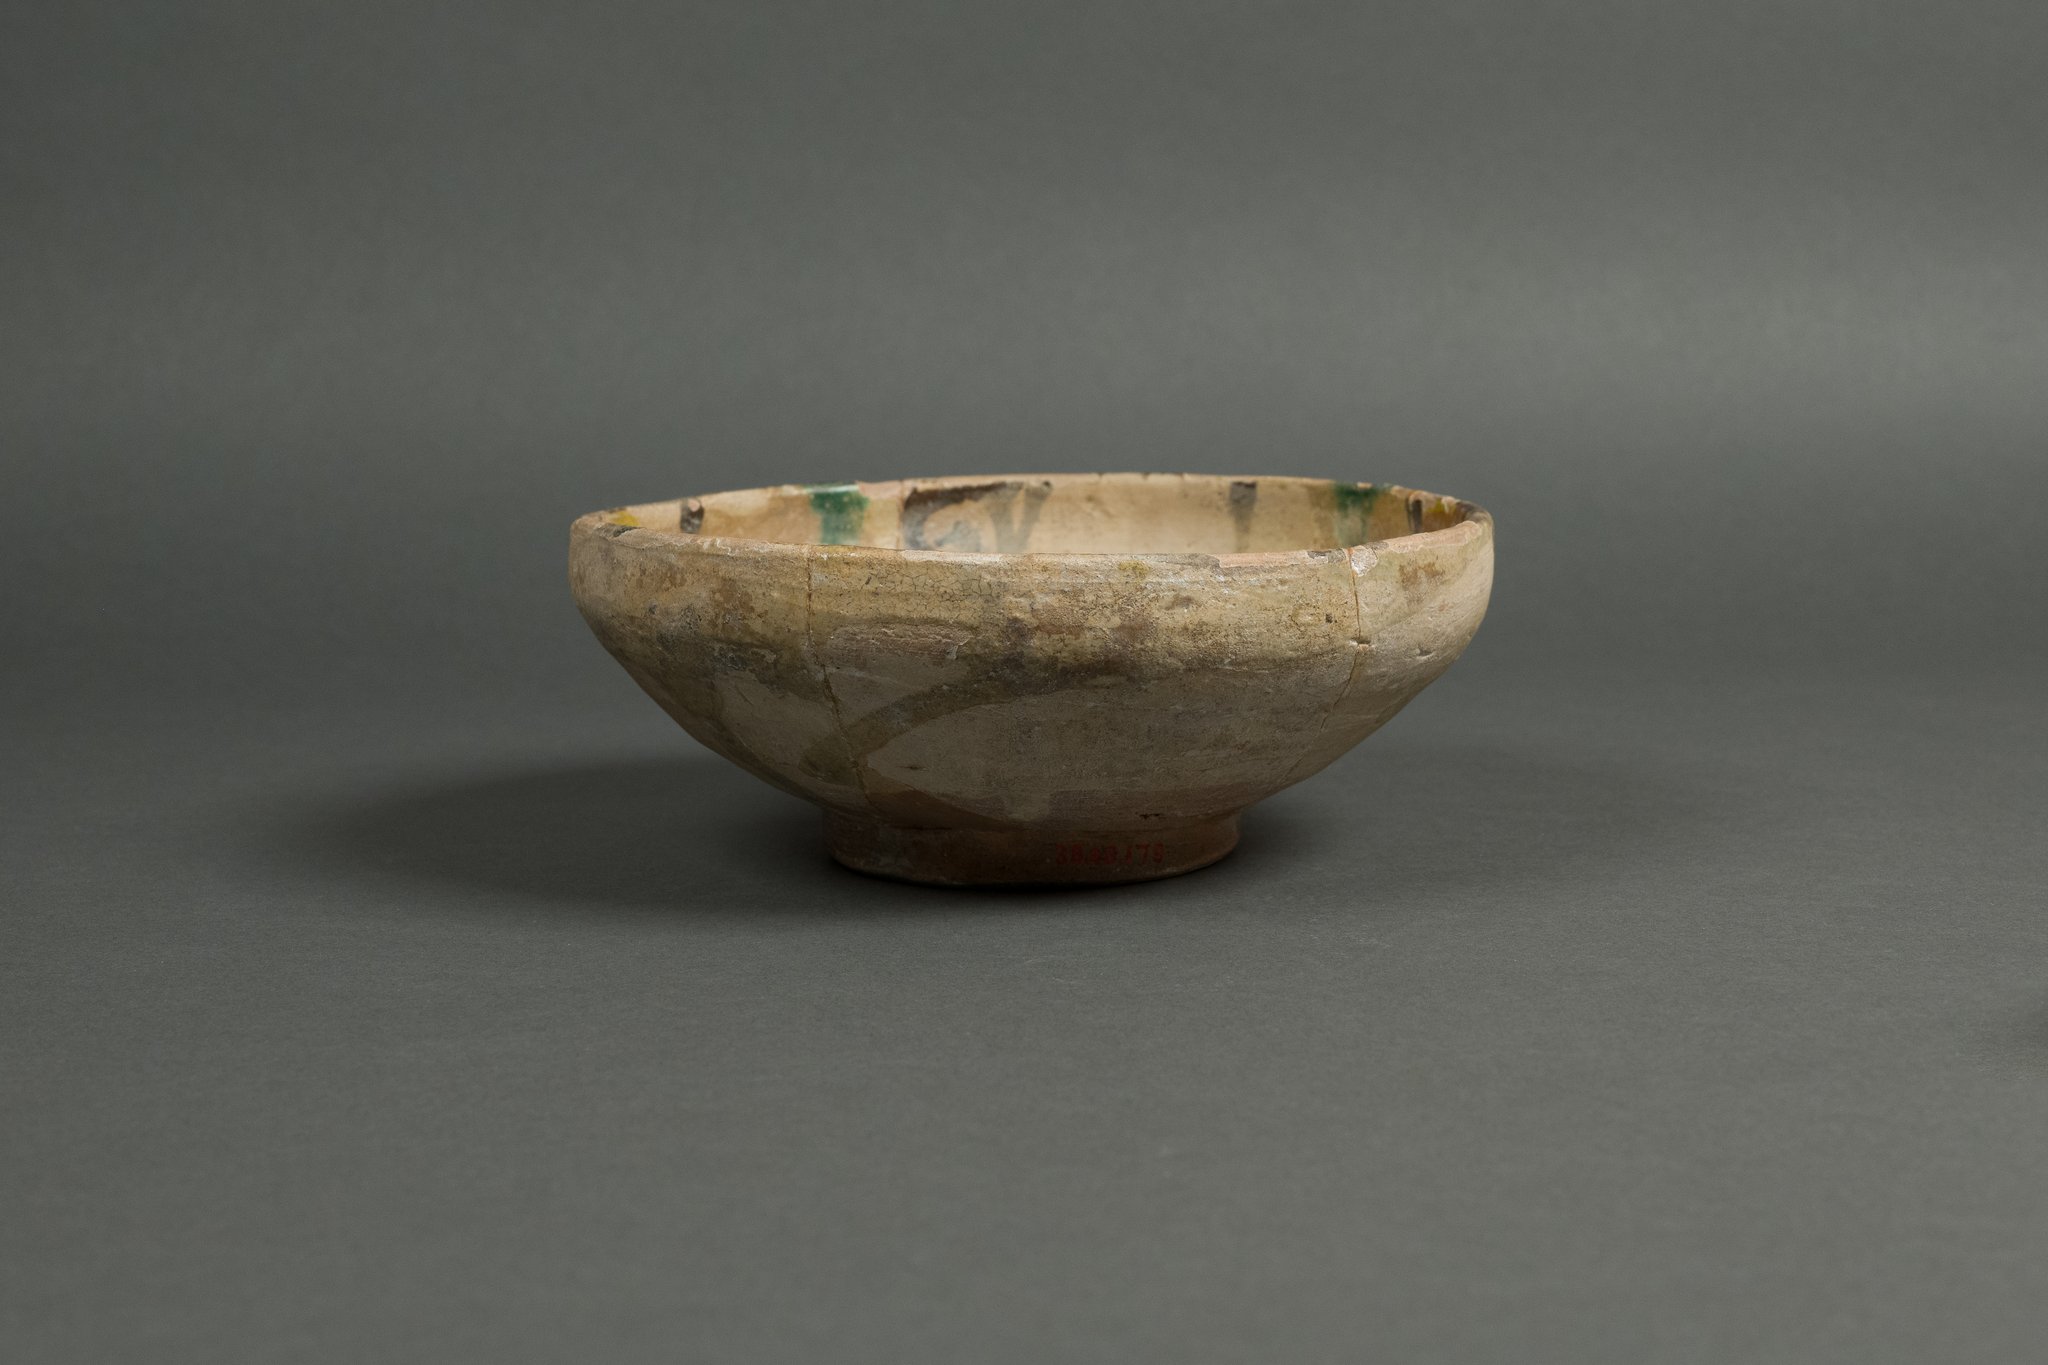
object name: bowl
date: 801-1000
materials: earthenware, glaze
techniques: polychrome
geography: iran